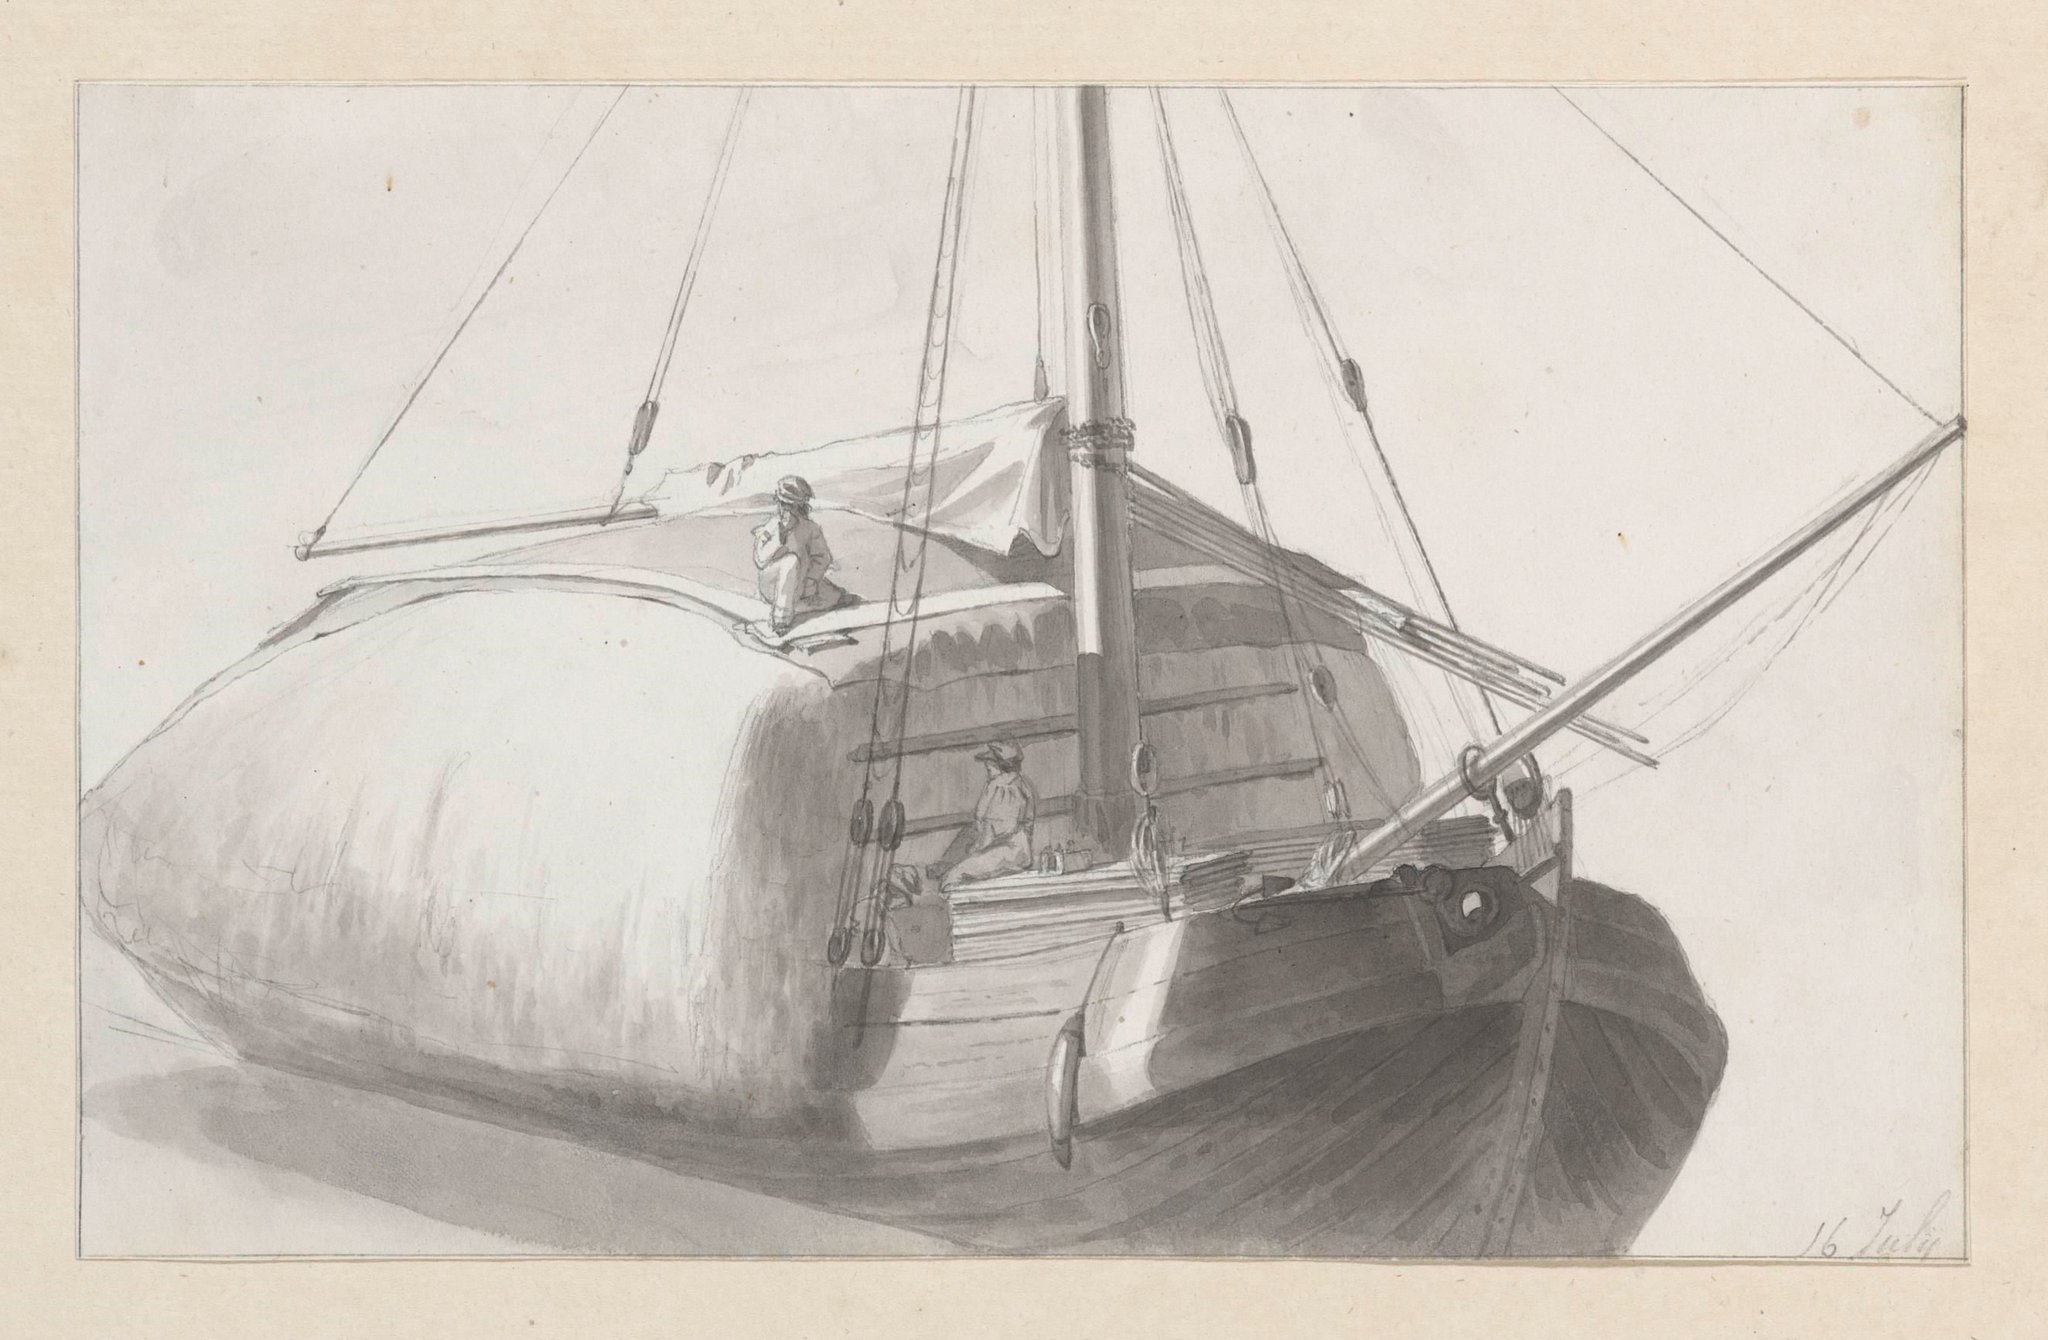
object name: drawing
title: Een boot met een lading hooi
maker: hendrik abraham klinkhamer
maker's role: draughtsman, painter, print maker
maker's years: 1810-1872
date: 1820-1872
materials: paper, pencil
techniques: brush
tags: sailing-ship, sailing-boat